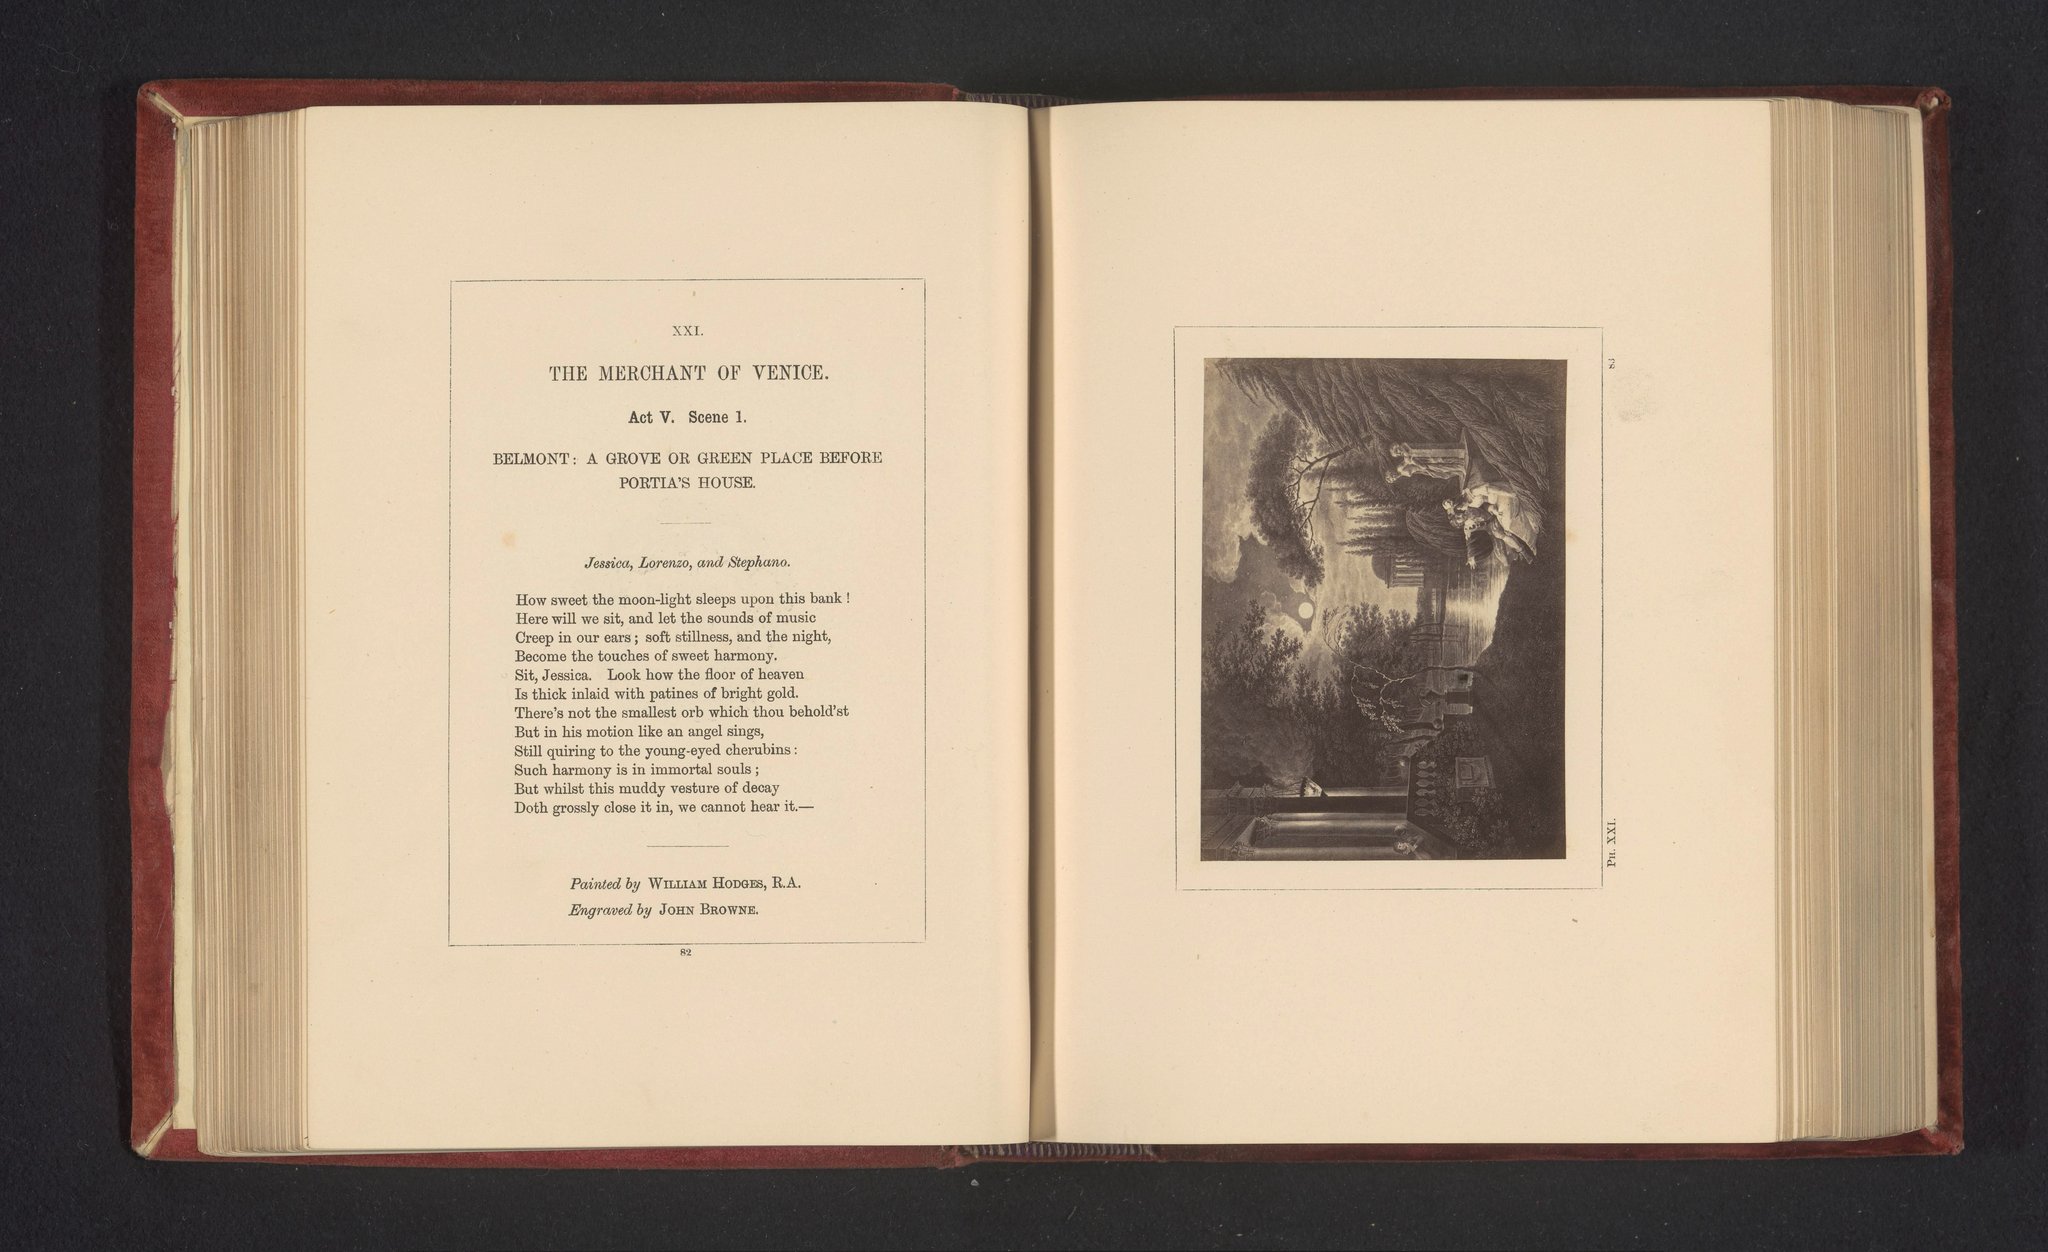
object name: reproduction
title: Fotoreproductie van een prent naar een schilderij door William Hodges, voorstellend een scene uit De koopman van Venetië door William Shakespeare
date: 1854-1864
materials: photographic support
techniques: albumen print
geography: london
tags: specific works of literature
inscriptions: number: ‘Ph. XXI. 83’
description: Te zien is akte V, scene 1 met Jessica en Lorenzo op een bankje en Stephano die toekijkt.